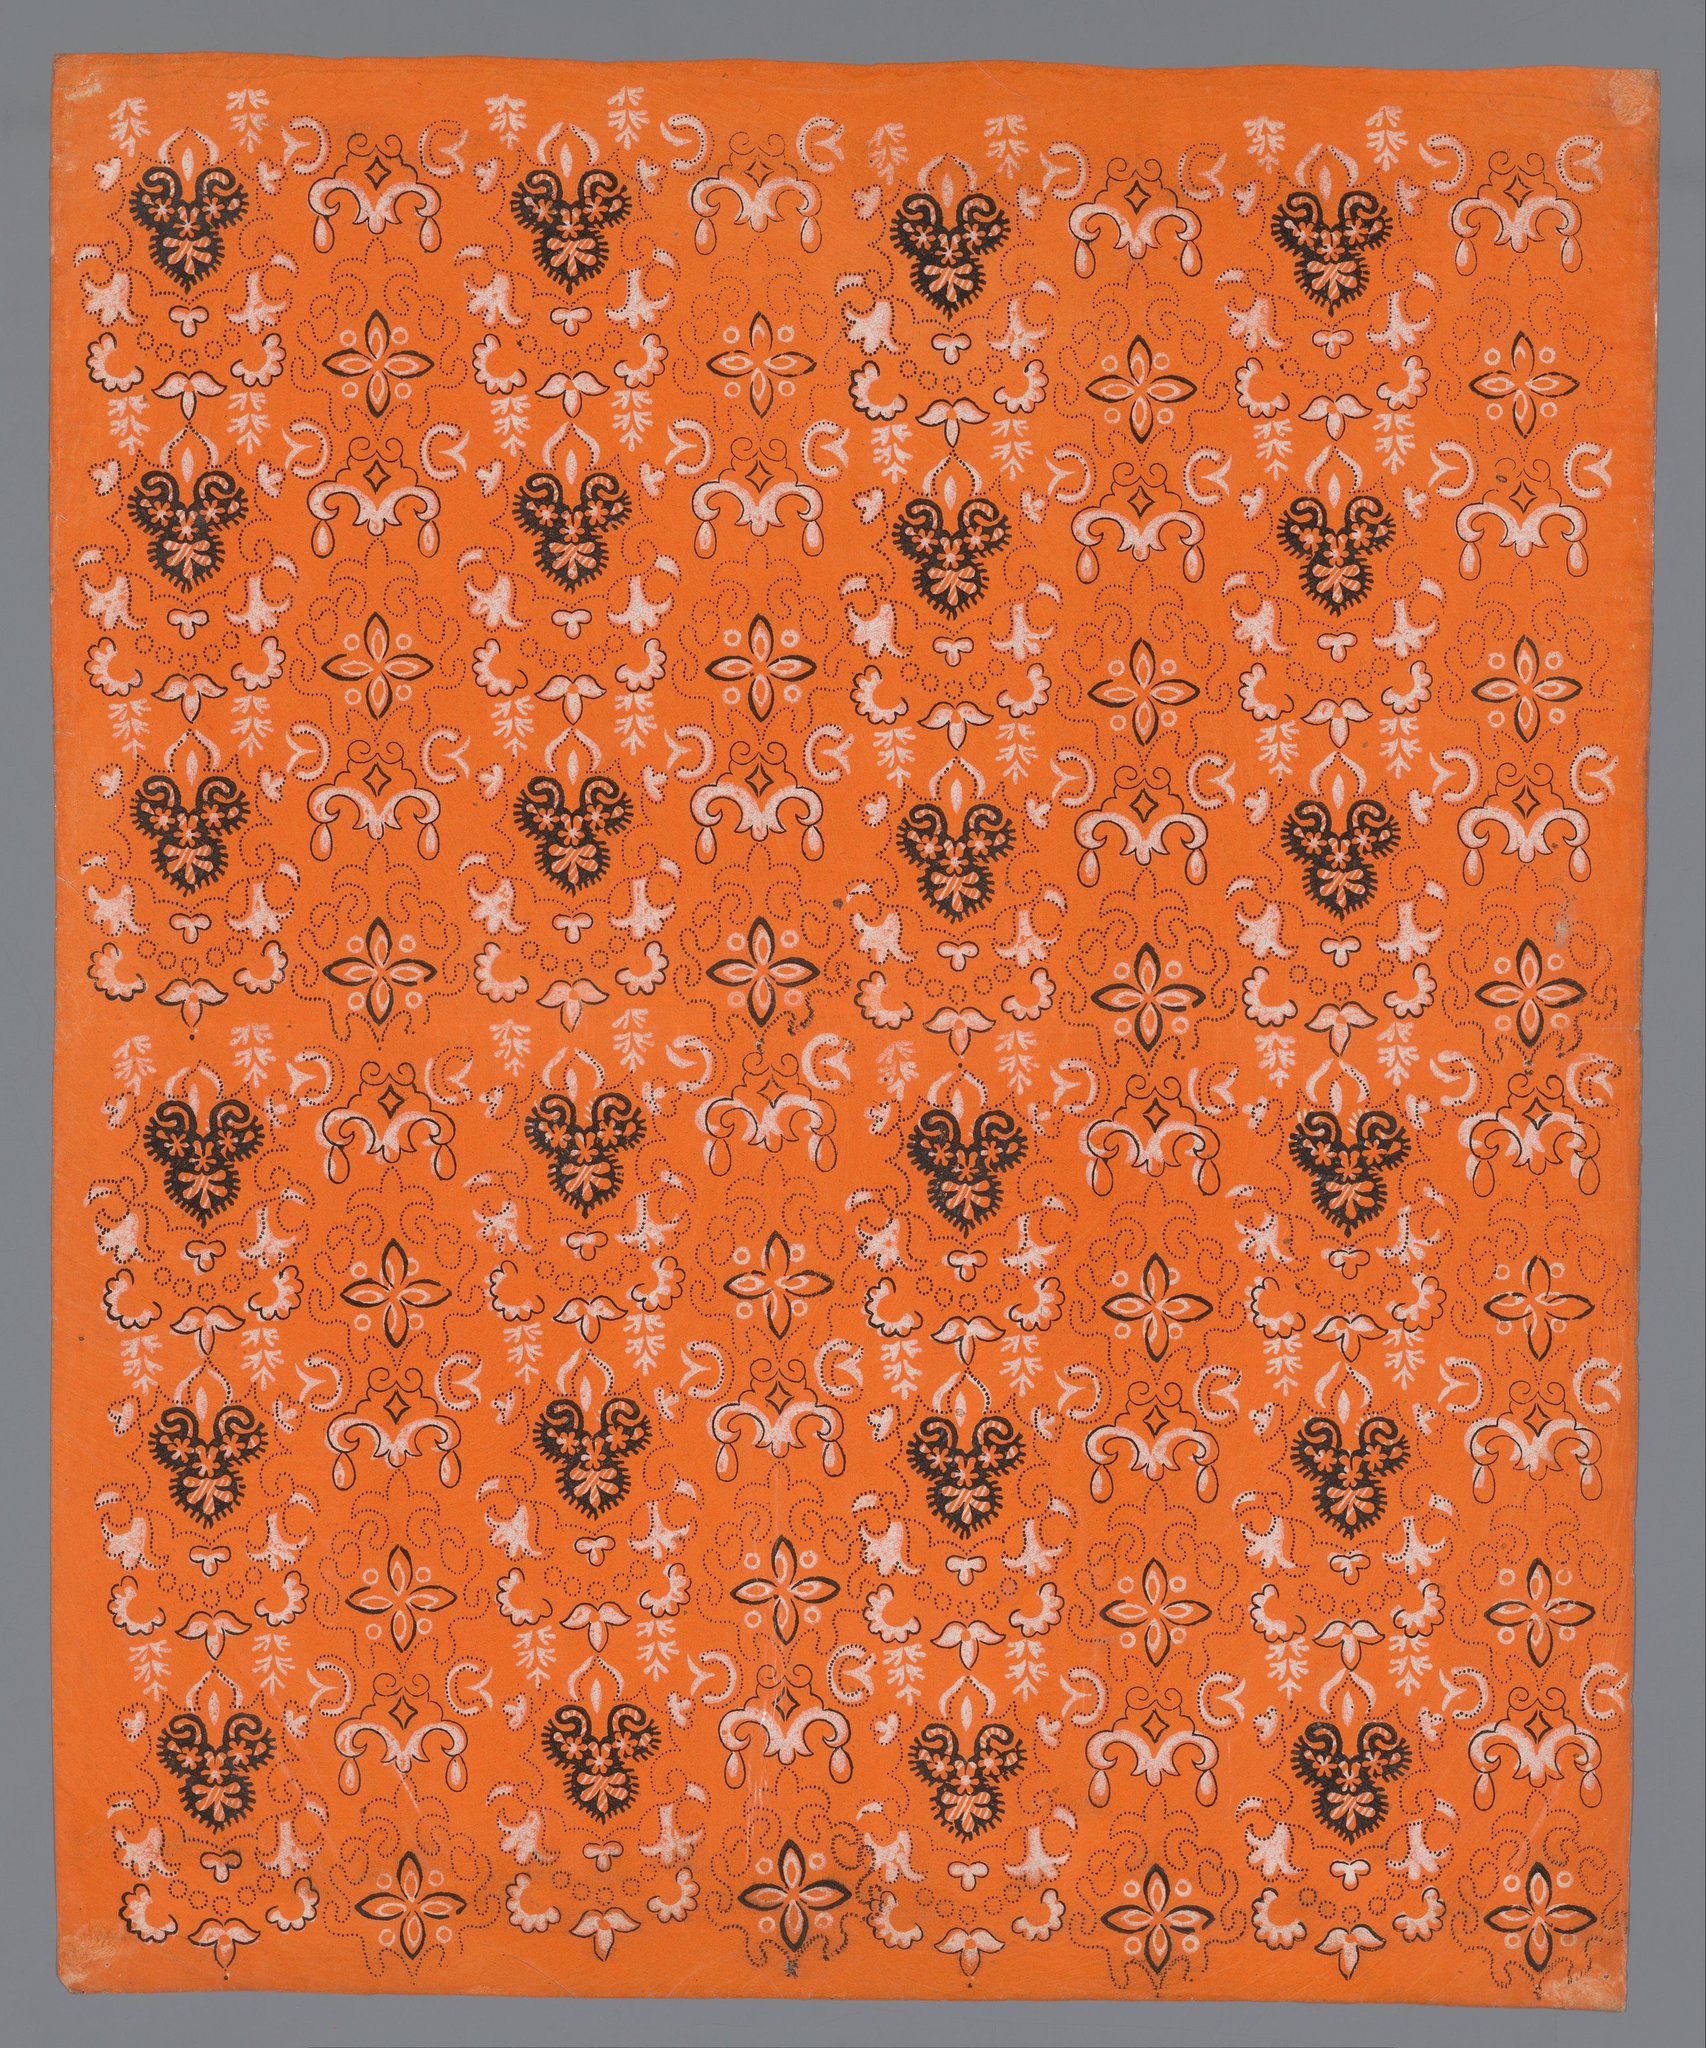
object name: printed paper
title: Blad met ornamenteel patroon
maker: Anonymous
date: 1850-1950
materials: lacquer, paint, paper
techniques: printing block, lacquer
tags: ornament derived from plant forms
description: Blad met een ornamenteel patroon van bloemen en lijstwerk met hangende bellen.